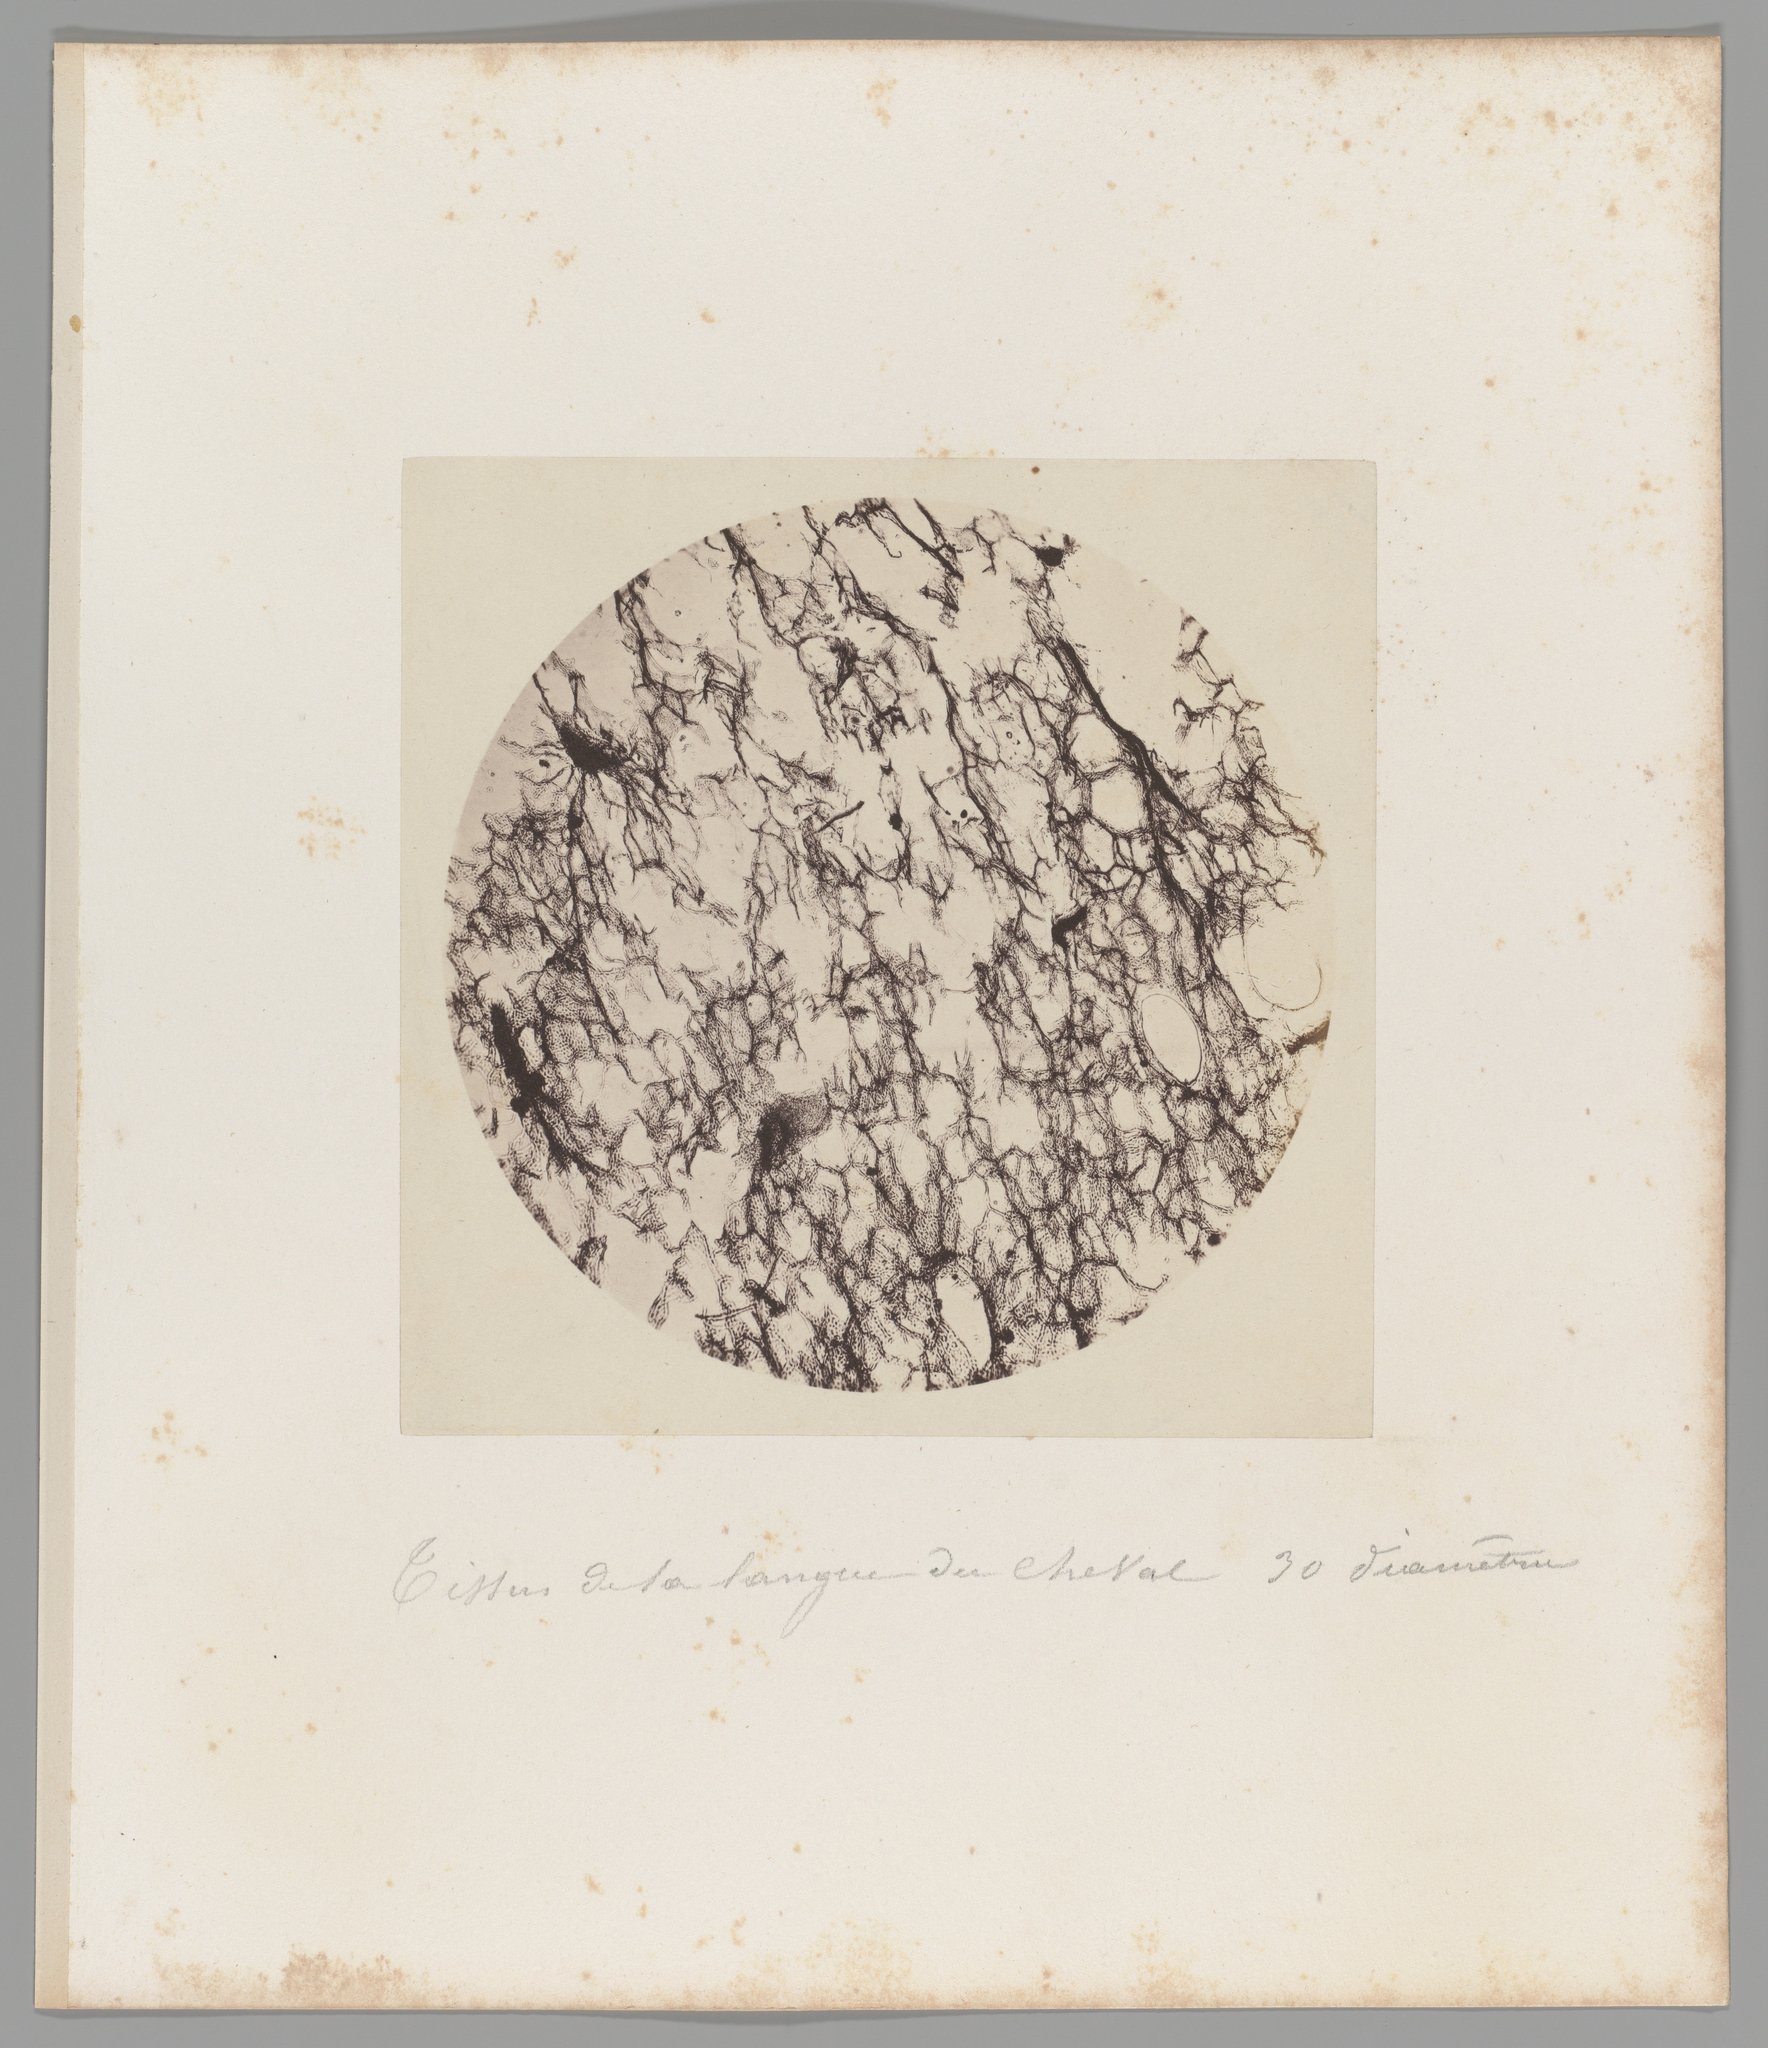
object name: photograph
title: [Untitled]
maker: auguste-adolphe bertsch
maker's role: artist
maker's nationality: french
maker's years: 1813-1871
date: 1853-1857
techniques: salted paper print